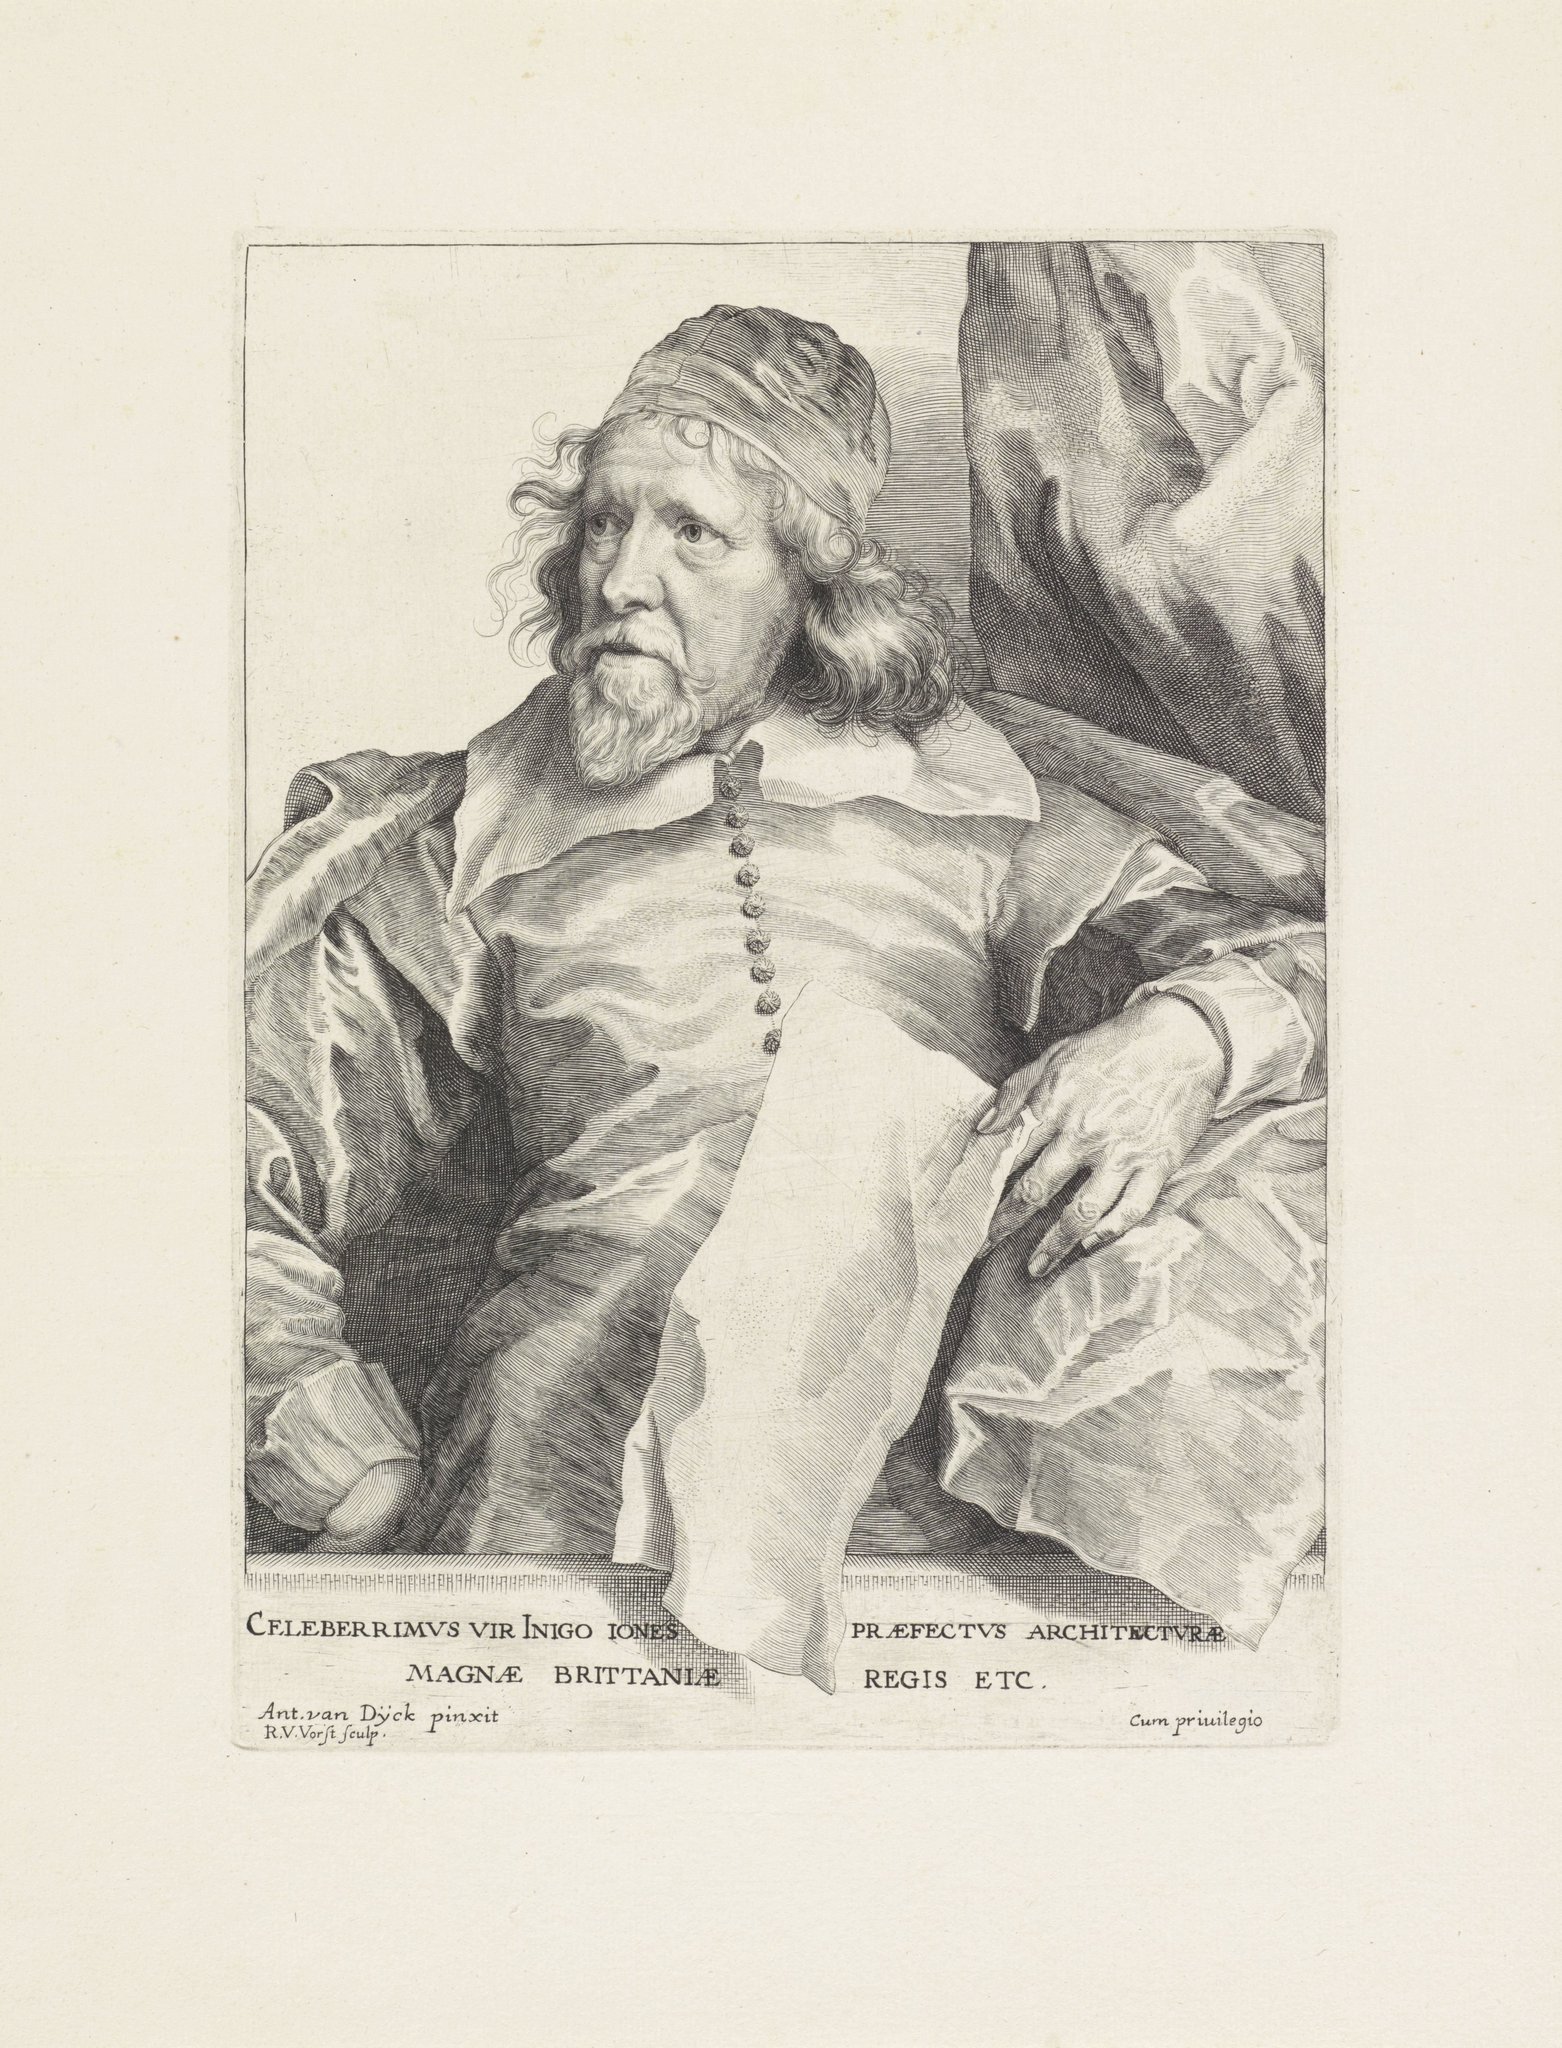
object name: print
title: Portret van Inigo Jones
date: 1627-1636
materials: paper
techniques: engraving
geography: london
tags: london, physicist, paper (writing material)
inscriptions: collector's mark: Lugt 2166, collector's mark: Lugt 2228, collector's mark: Lugt 2760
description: Portet van de Engelse architect Inigo Jones. In zijn hand een vel papier.